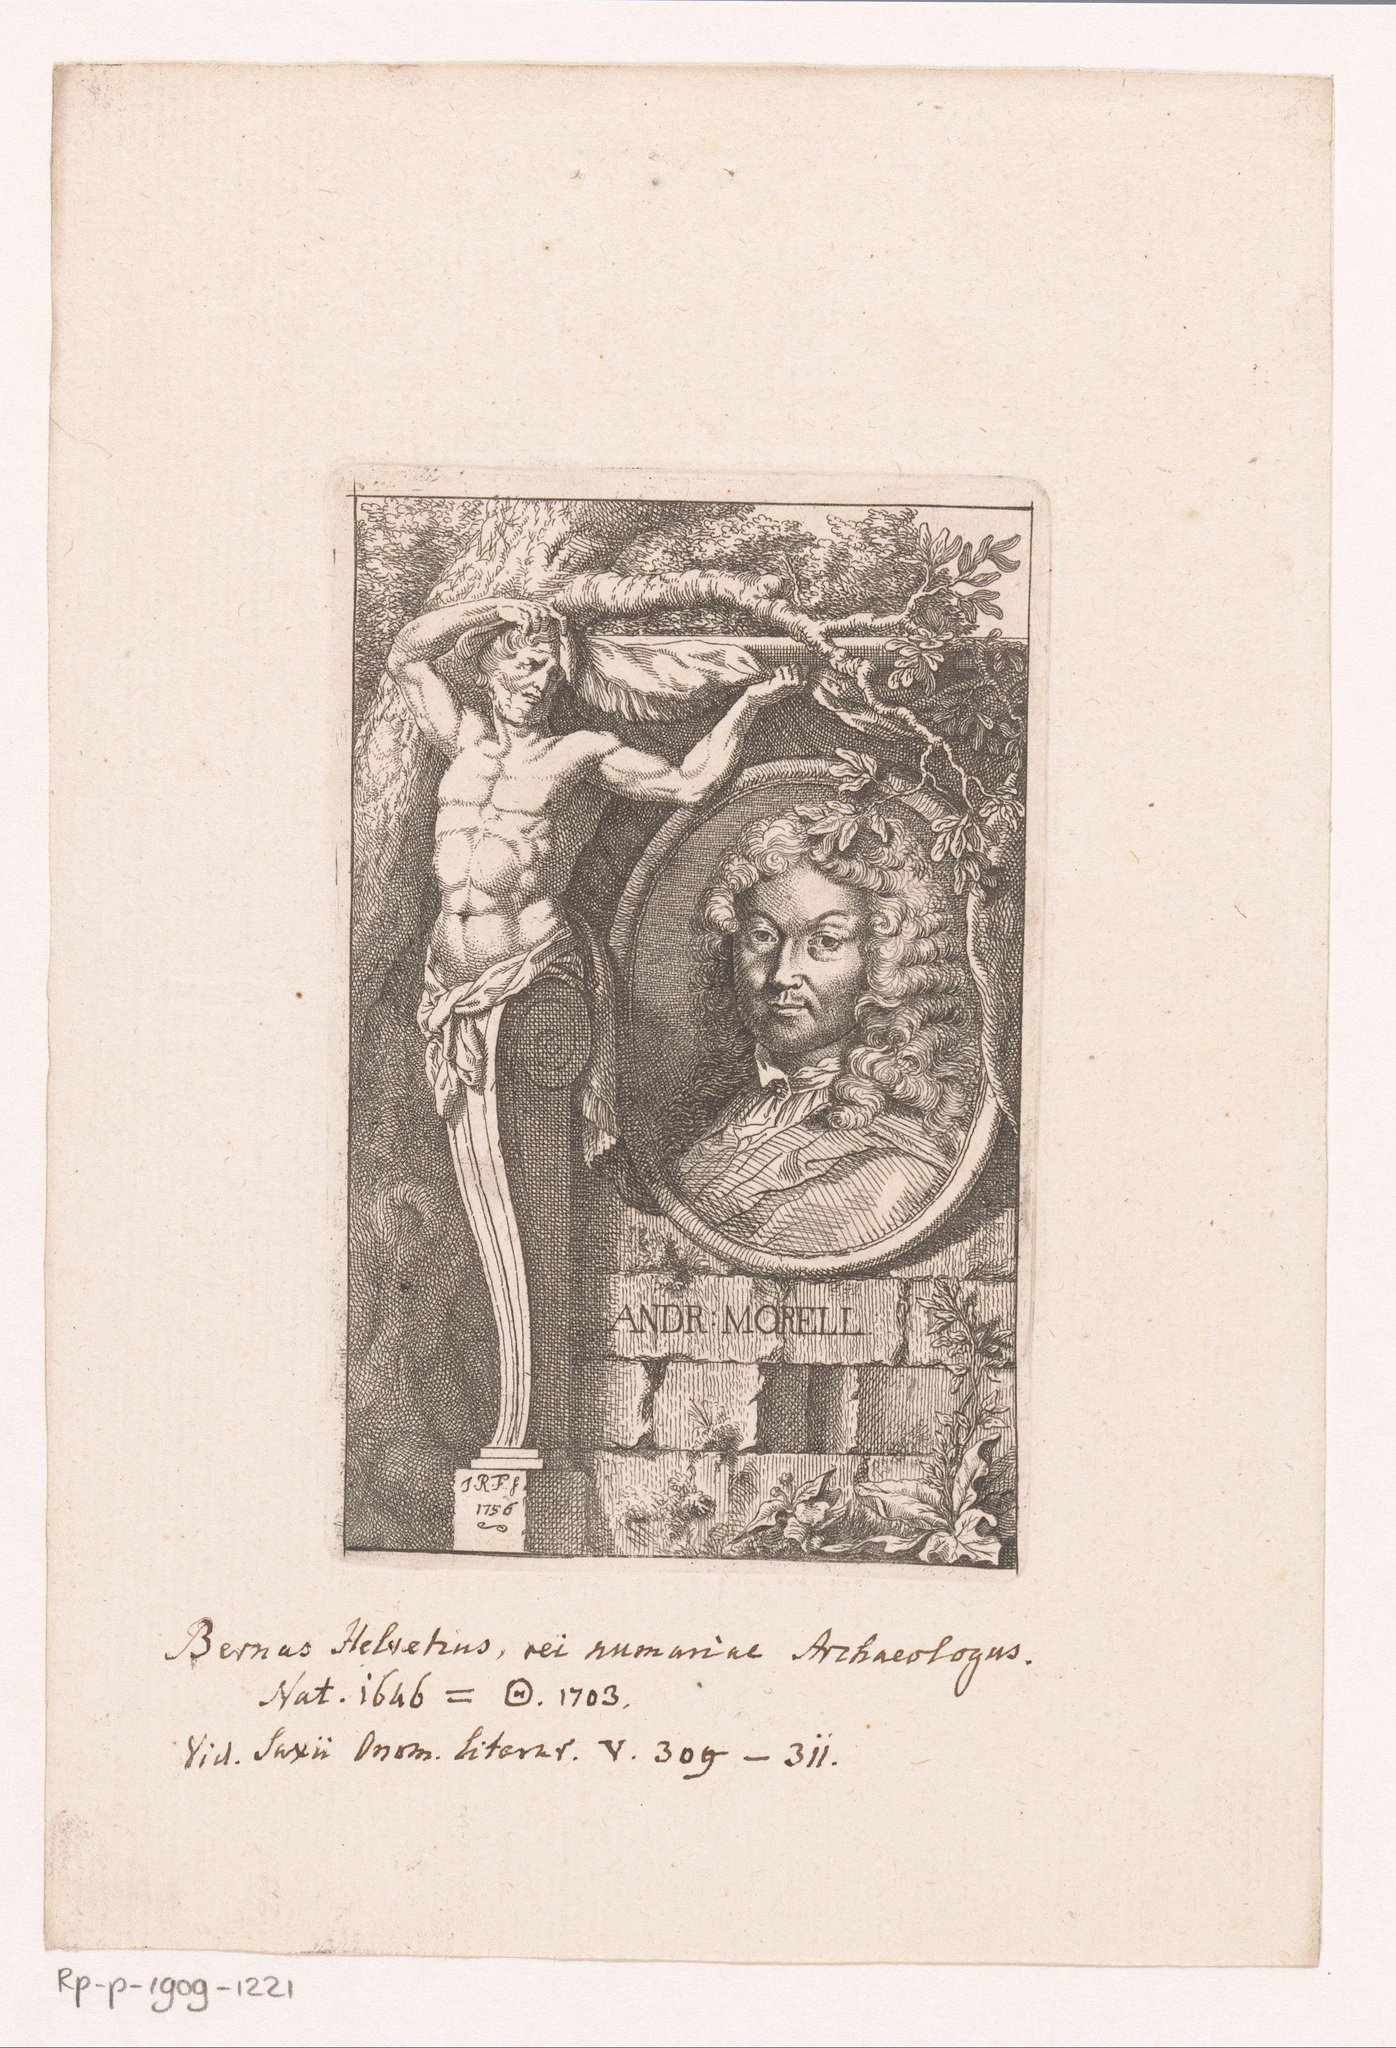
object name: print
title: Portret van Andreas Morell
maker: rudolf füssli (der jüngste)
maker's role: print maker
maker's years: 1737-1806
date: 1756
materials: paper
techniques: etching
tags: plants; vegetation, herms (garden ornaments), ornament ~ medallion, historical persons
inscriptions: collector's mark: Lugt 2228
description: Prent gebruikt voor: Füssli, Johann Kaspar. Geschichte Und Abbildung der besten Mahler in der Schweitz. Zürich: David Gessner, 1755-1757.